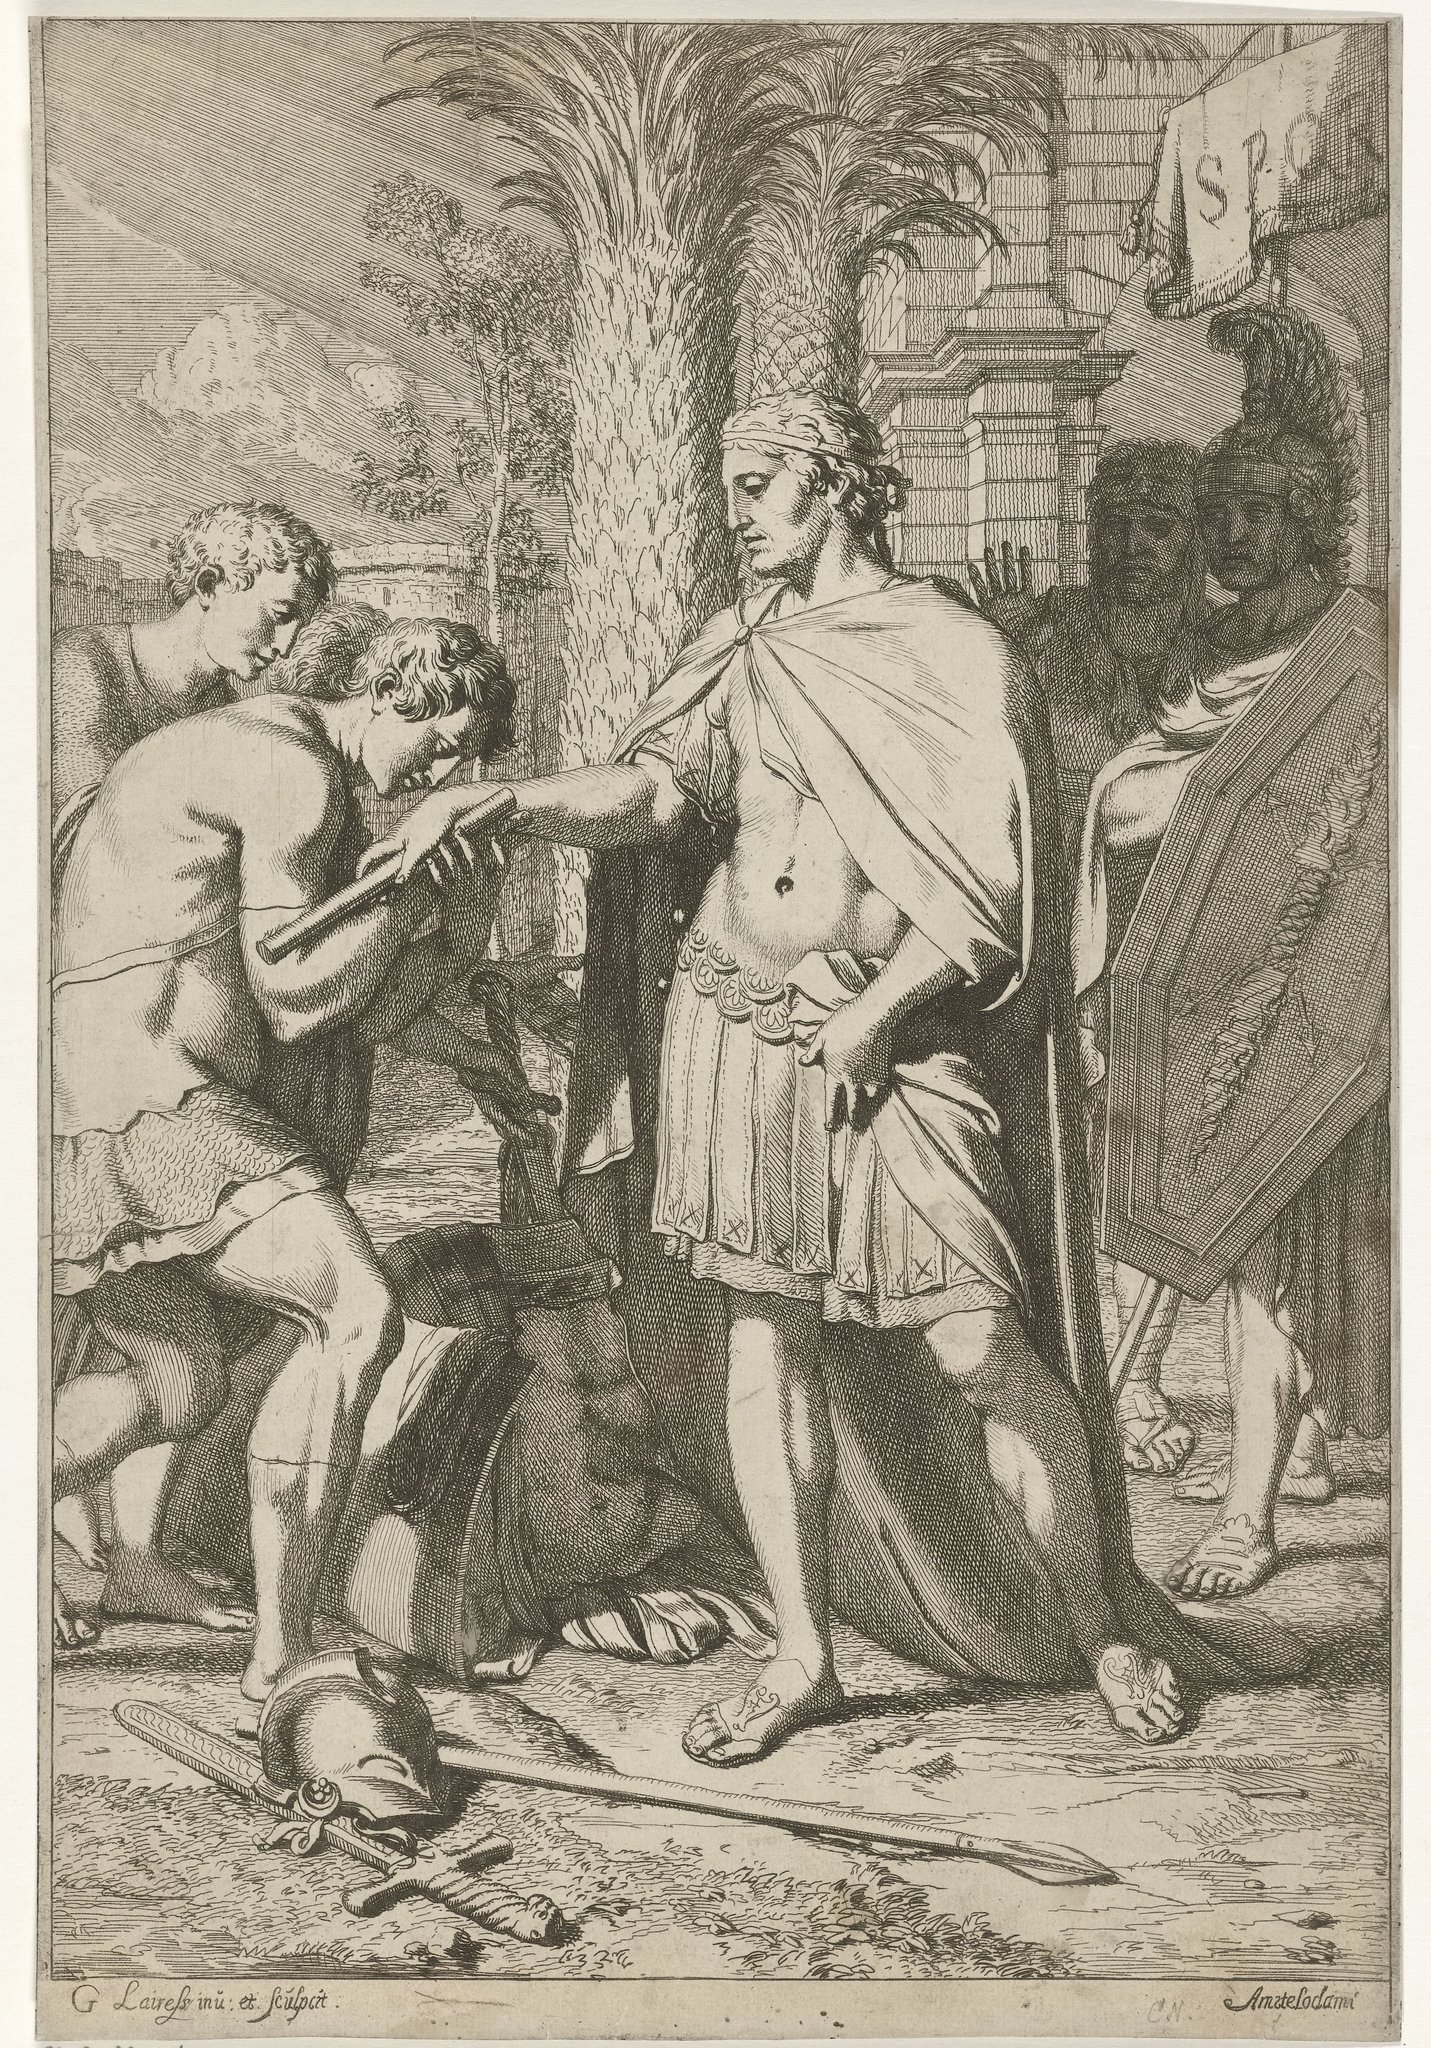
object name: print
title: Veldheer schenkt verslagen krijgslieden genade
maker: gerard de lairesse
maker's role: draughtsman, painter, print maker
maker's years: 1641-1711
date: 1670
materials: paper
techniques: etching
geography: amsterdam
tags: forgivingness (+ symbolical representation of concept), the defeated before the victor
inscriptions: collector's mark: Lugt 2228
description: Twee verslagen krijgslieden ontvangen genade van een Romeins veldheer. Buigend kussen ze zijn hand waarin hij een scepter vasthoudt. Deze prent illustreert het eerste deel van het door Vergilius opgenomen grondbeginsel van de Romeinse politiek: "Parcere subiectis, sed debellare superbos" (Vergilius, Aeneïs 6.853). Volgens dit beginsel zouden de onderworpenen worden gespaard, maar zij die zich hardnekkig bleven verzetten werden vernietigd. Pendant van een prent over het tweede deel van deze stelregel.